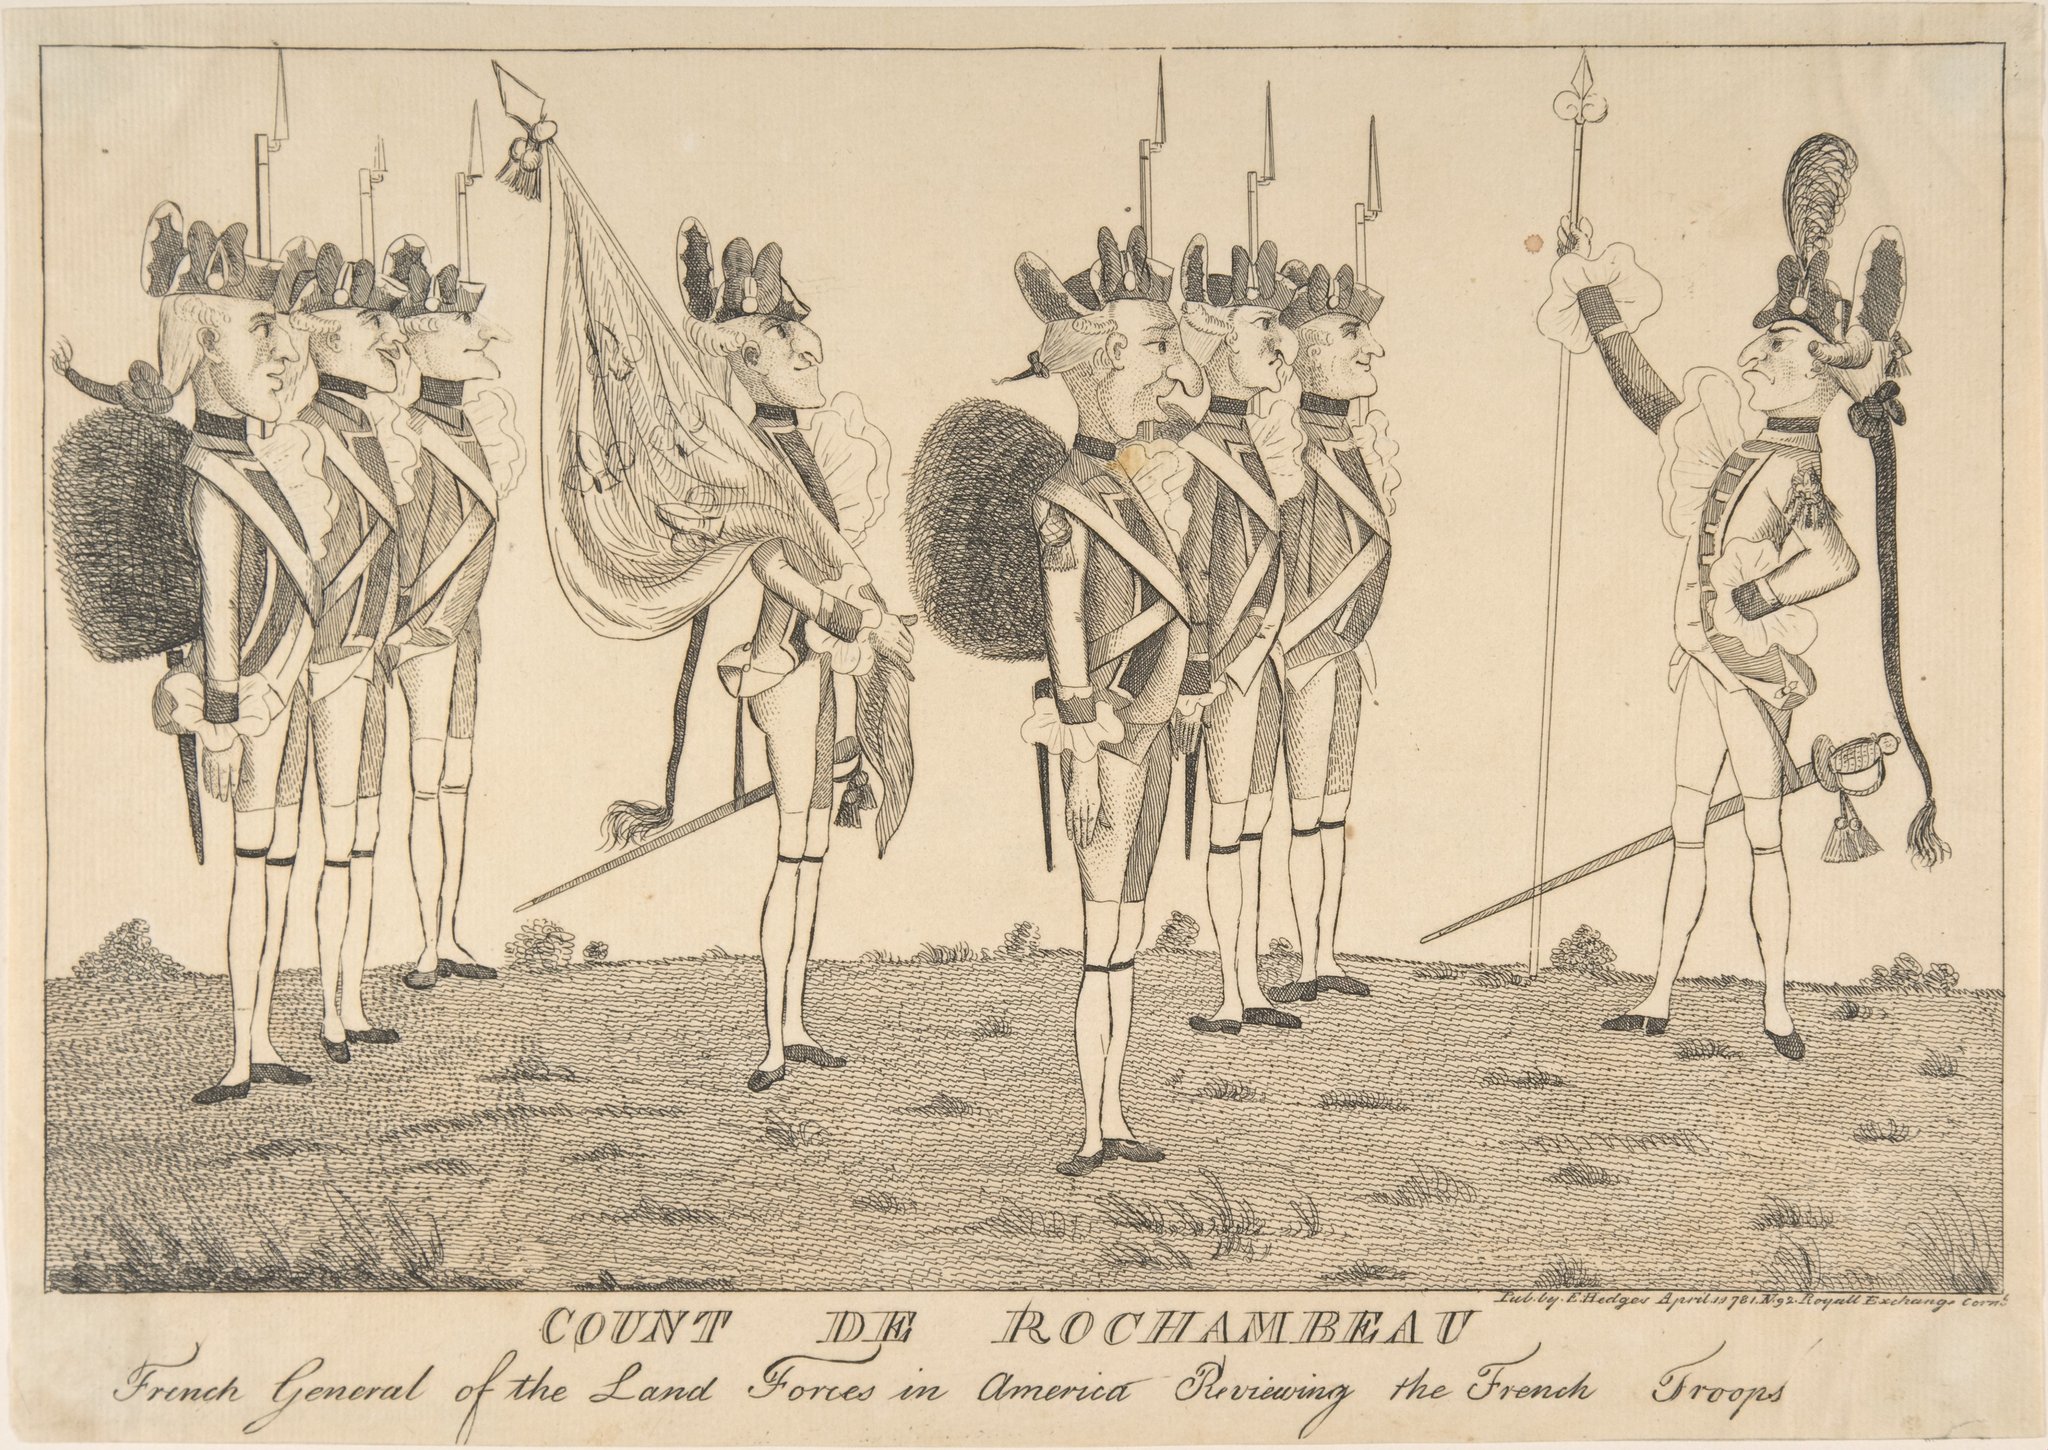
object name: print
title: Count de Rochambeau, French General of the Land Forces in America Reviewing the French Troops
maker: anonymous, british, 18th century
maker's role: artist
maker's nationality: british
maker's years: 1700-1800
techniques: engraving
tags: satire,soldiers,american revolution